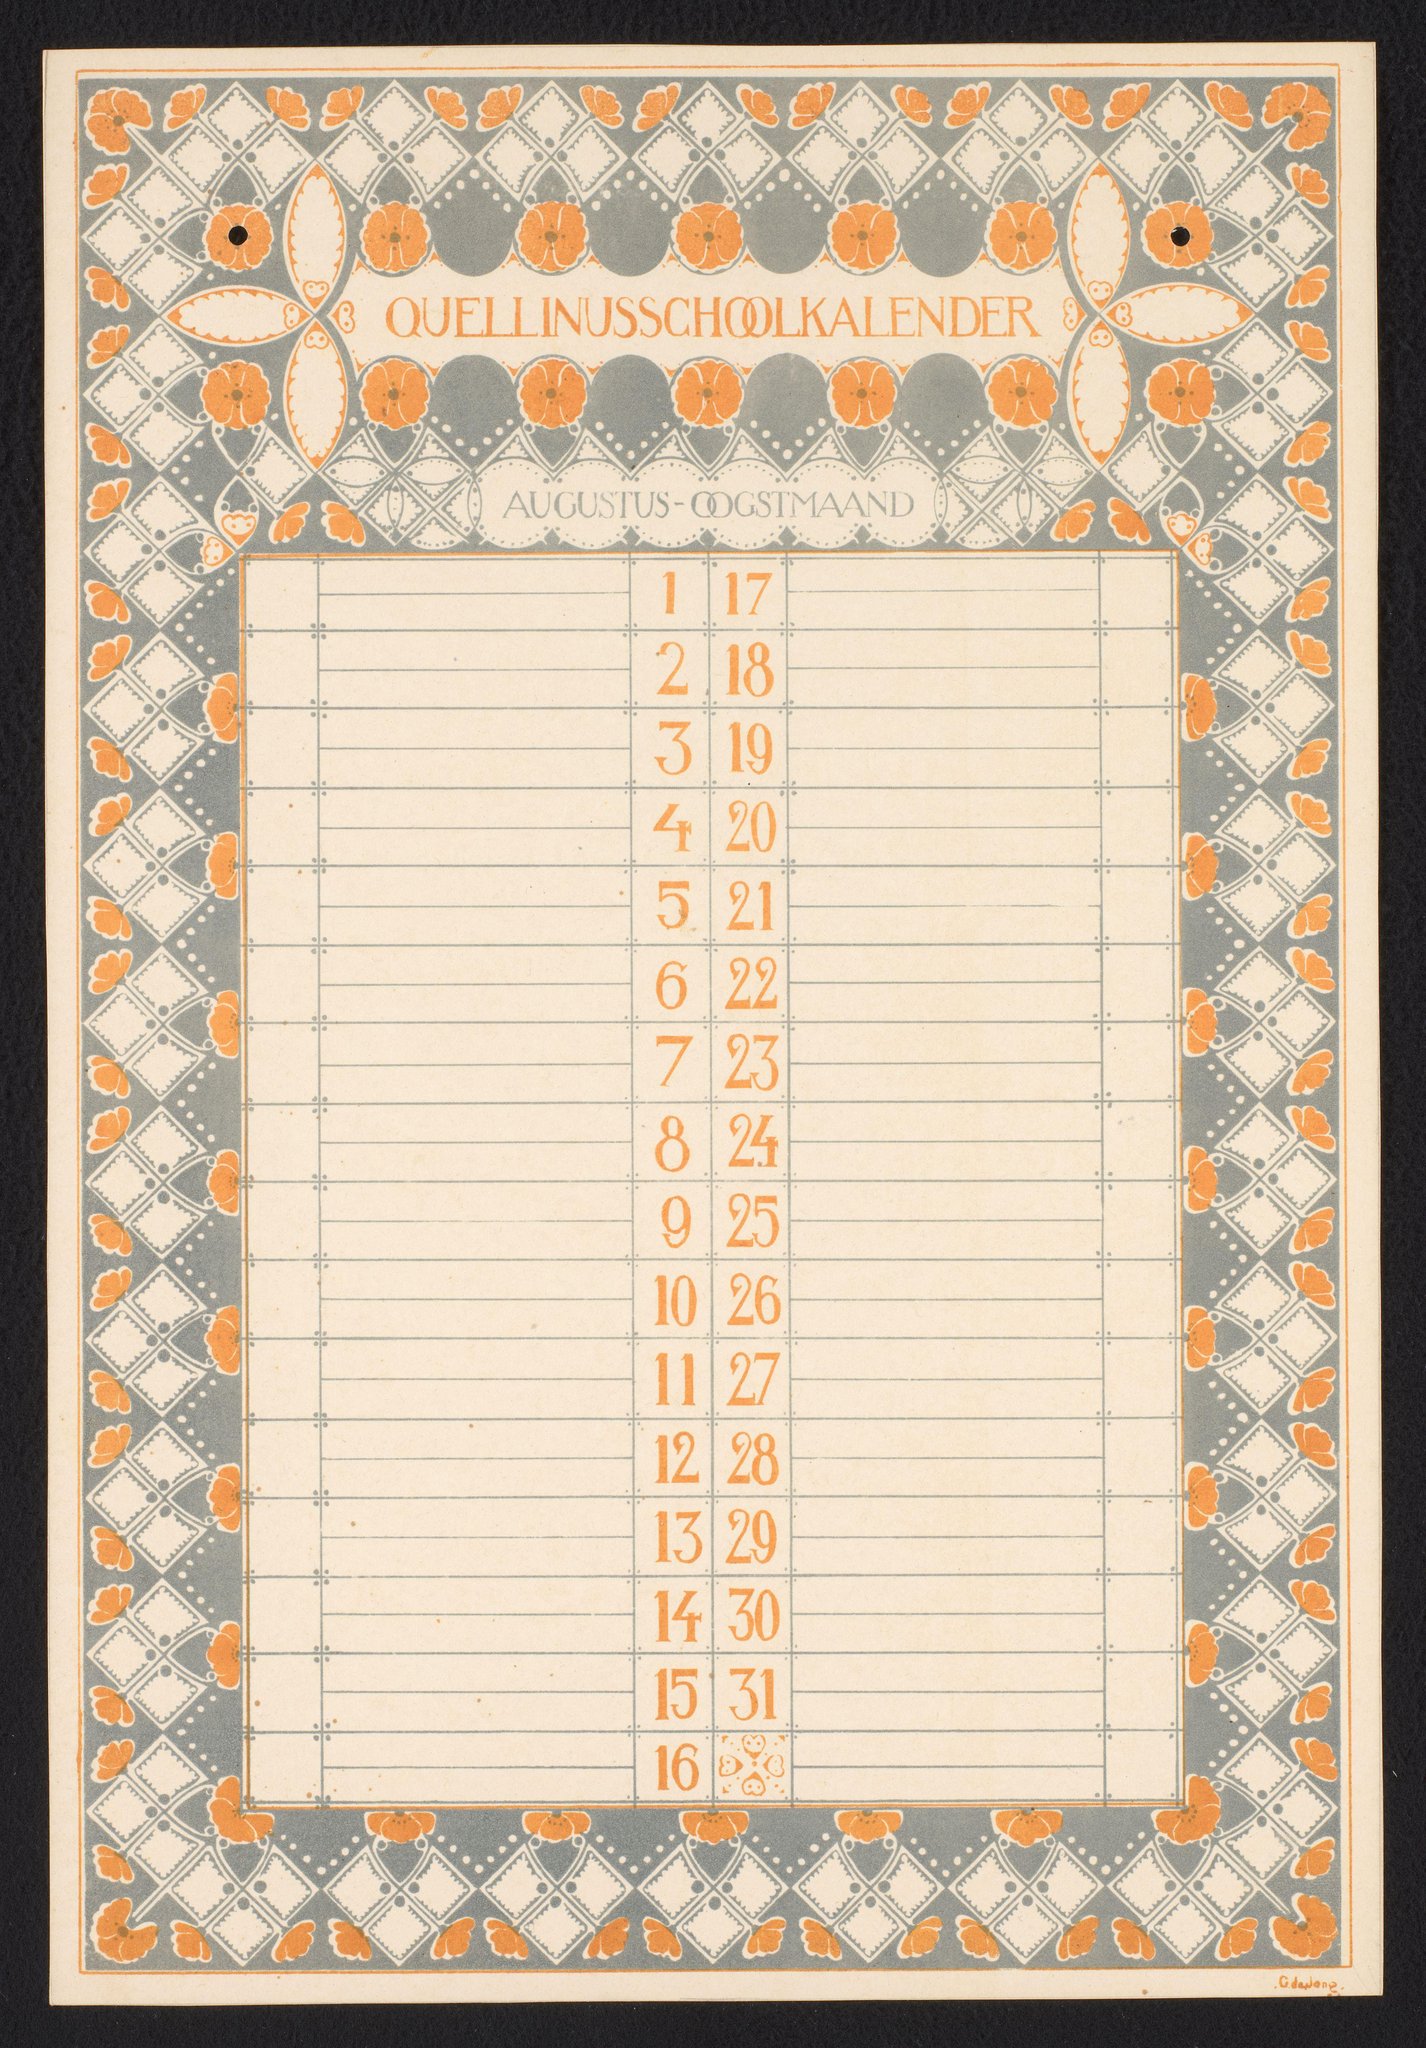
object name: calendar leaf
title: Kalenderblad voor de oogstmaand, augustus, van een kalender van Kunstnijverheidsschool Quellinus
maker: g. de jong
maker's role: print maker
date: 1885-1925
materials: paper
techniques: lithograph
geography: amsterdam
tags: plants (in general), ornaments ~ art, calendar, almanac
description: Bij gebrek aan gegevens over de vervaardiger is voor de bepaling van de rechten van dit object gebruik gemaakt van de vervaardigingsdatum.